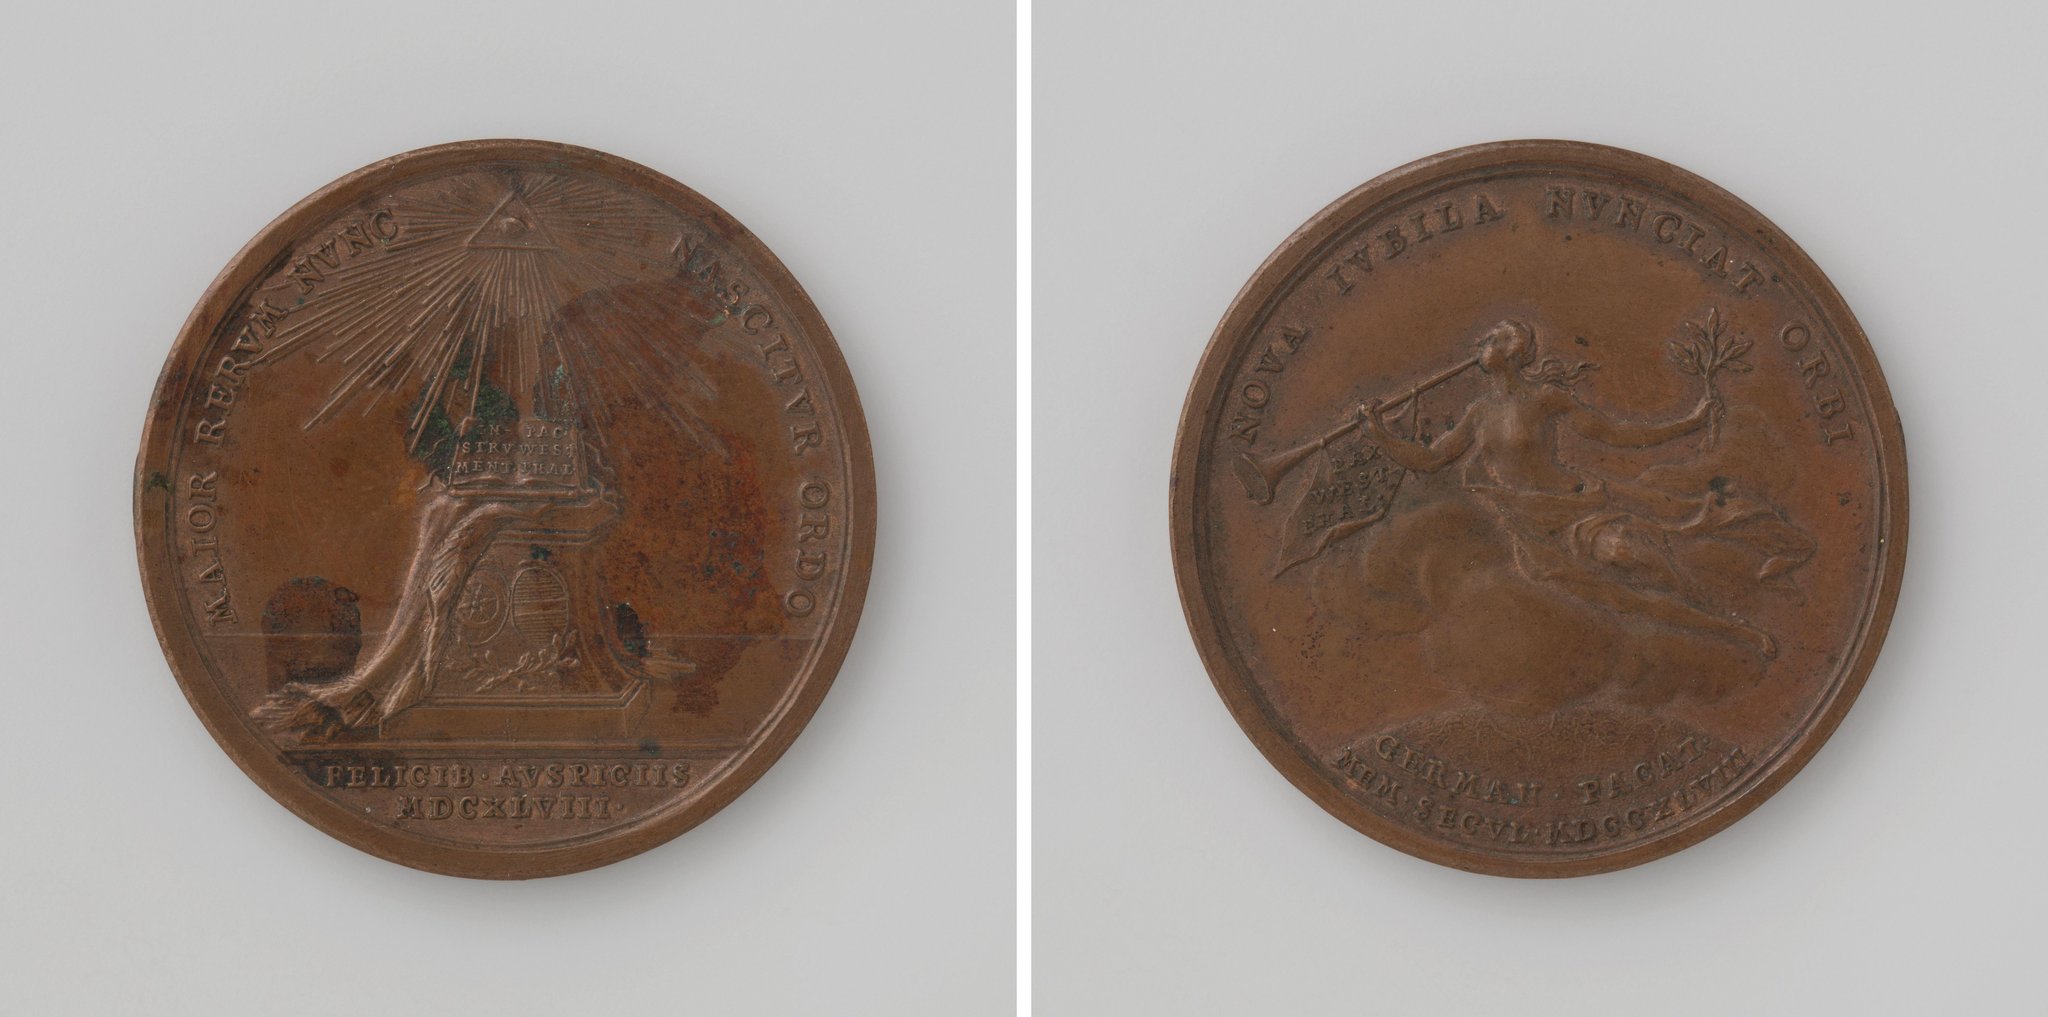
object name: medal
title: Penning over het eerste eeuwfeest van de Vrede van Munster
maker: Anonymous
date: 1748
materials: bronze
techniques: striking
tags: münster, tachtigjarige oorlog, vrede van münster